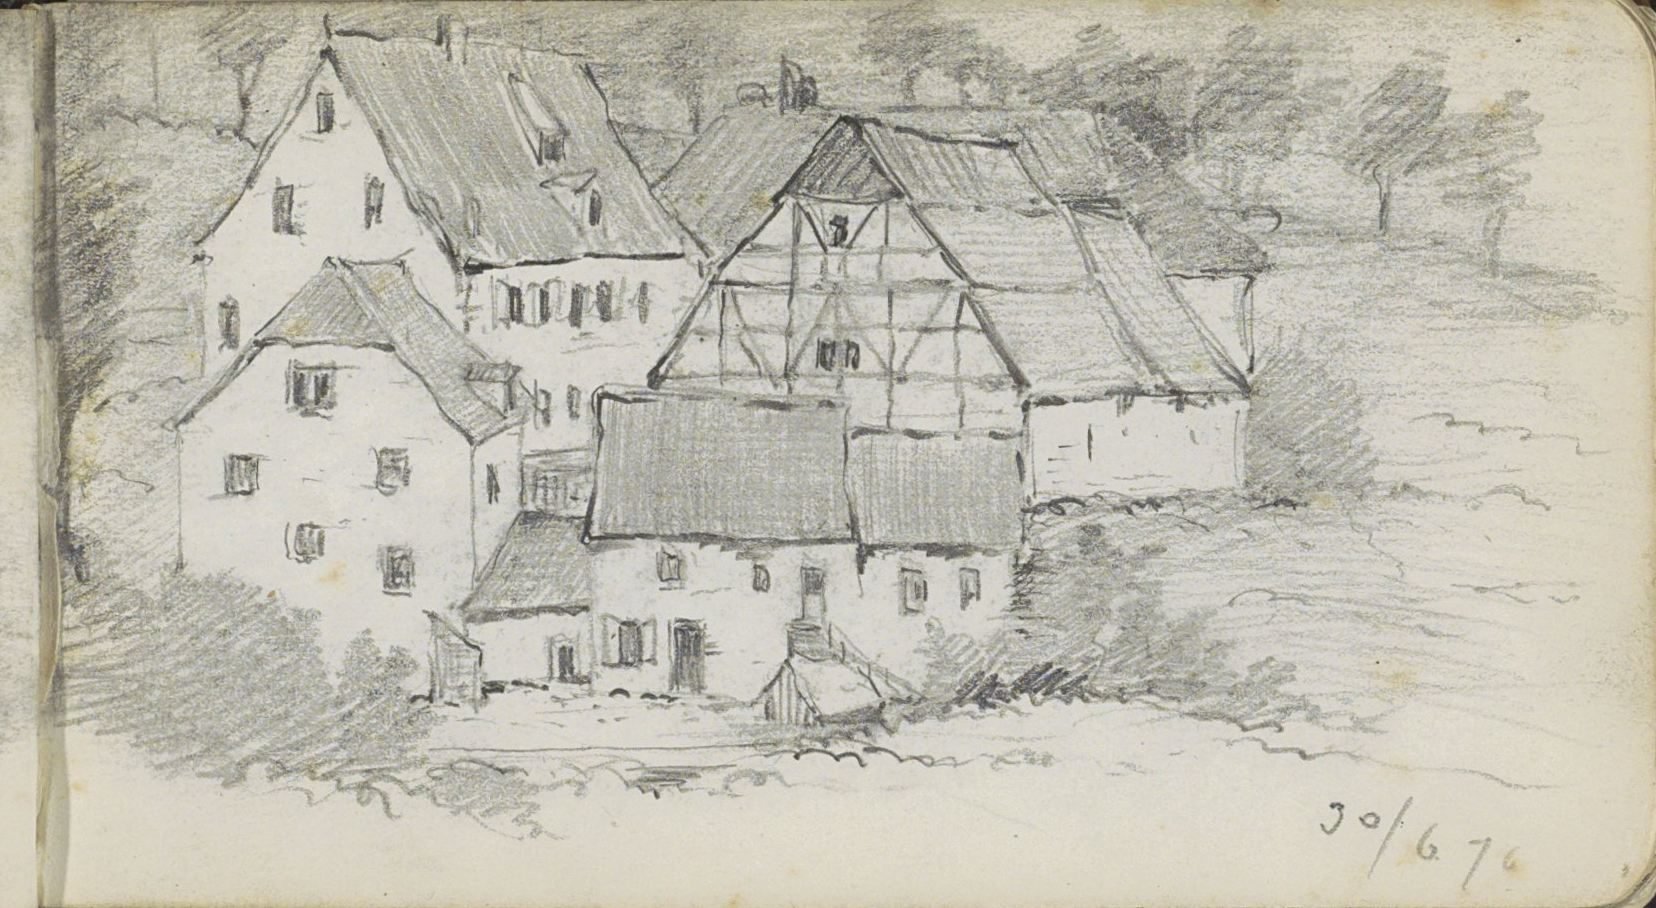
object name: sketchbook leaf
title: Huizen te Schlierbach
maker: geo poggenbeek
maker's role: draughtsman, painter, print maker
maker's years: 1853-1903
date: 1806-1876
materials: paper, pencil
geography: schlierbach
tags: cottage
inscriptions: date: ‘30/6 76’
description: Blad 10 recto uit een schetsboek met 69 bladen.